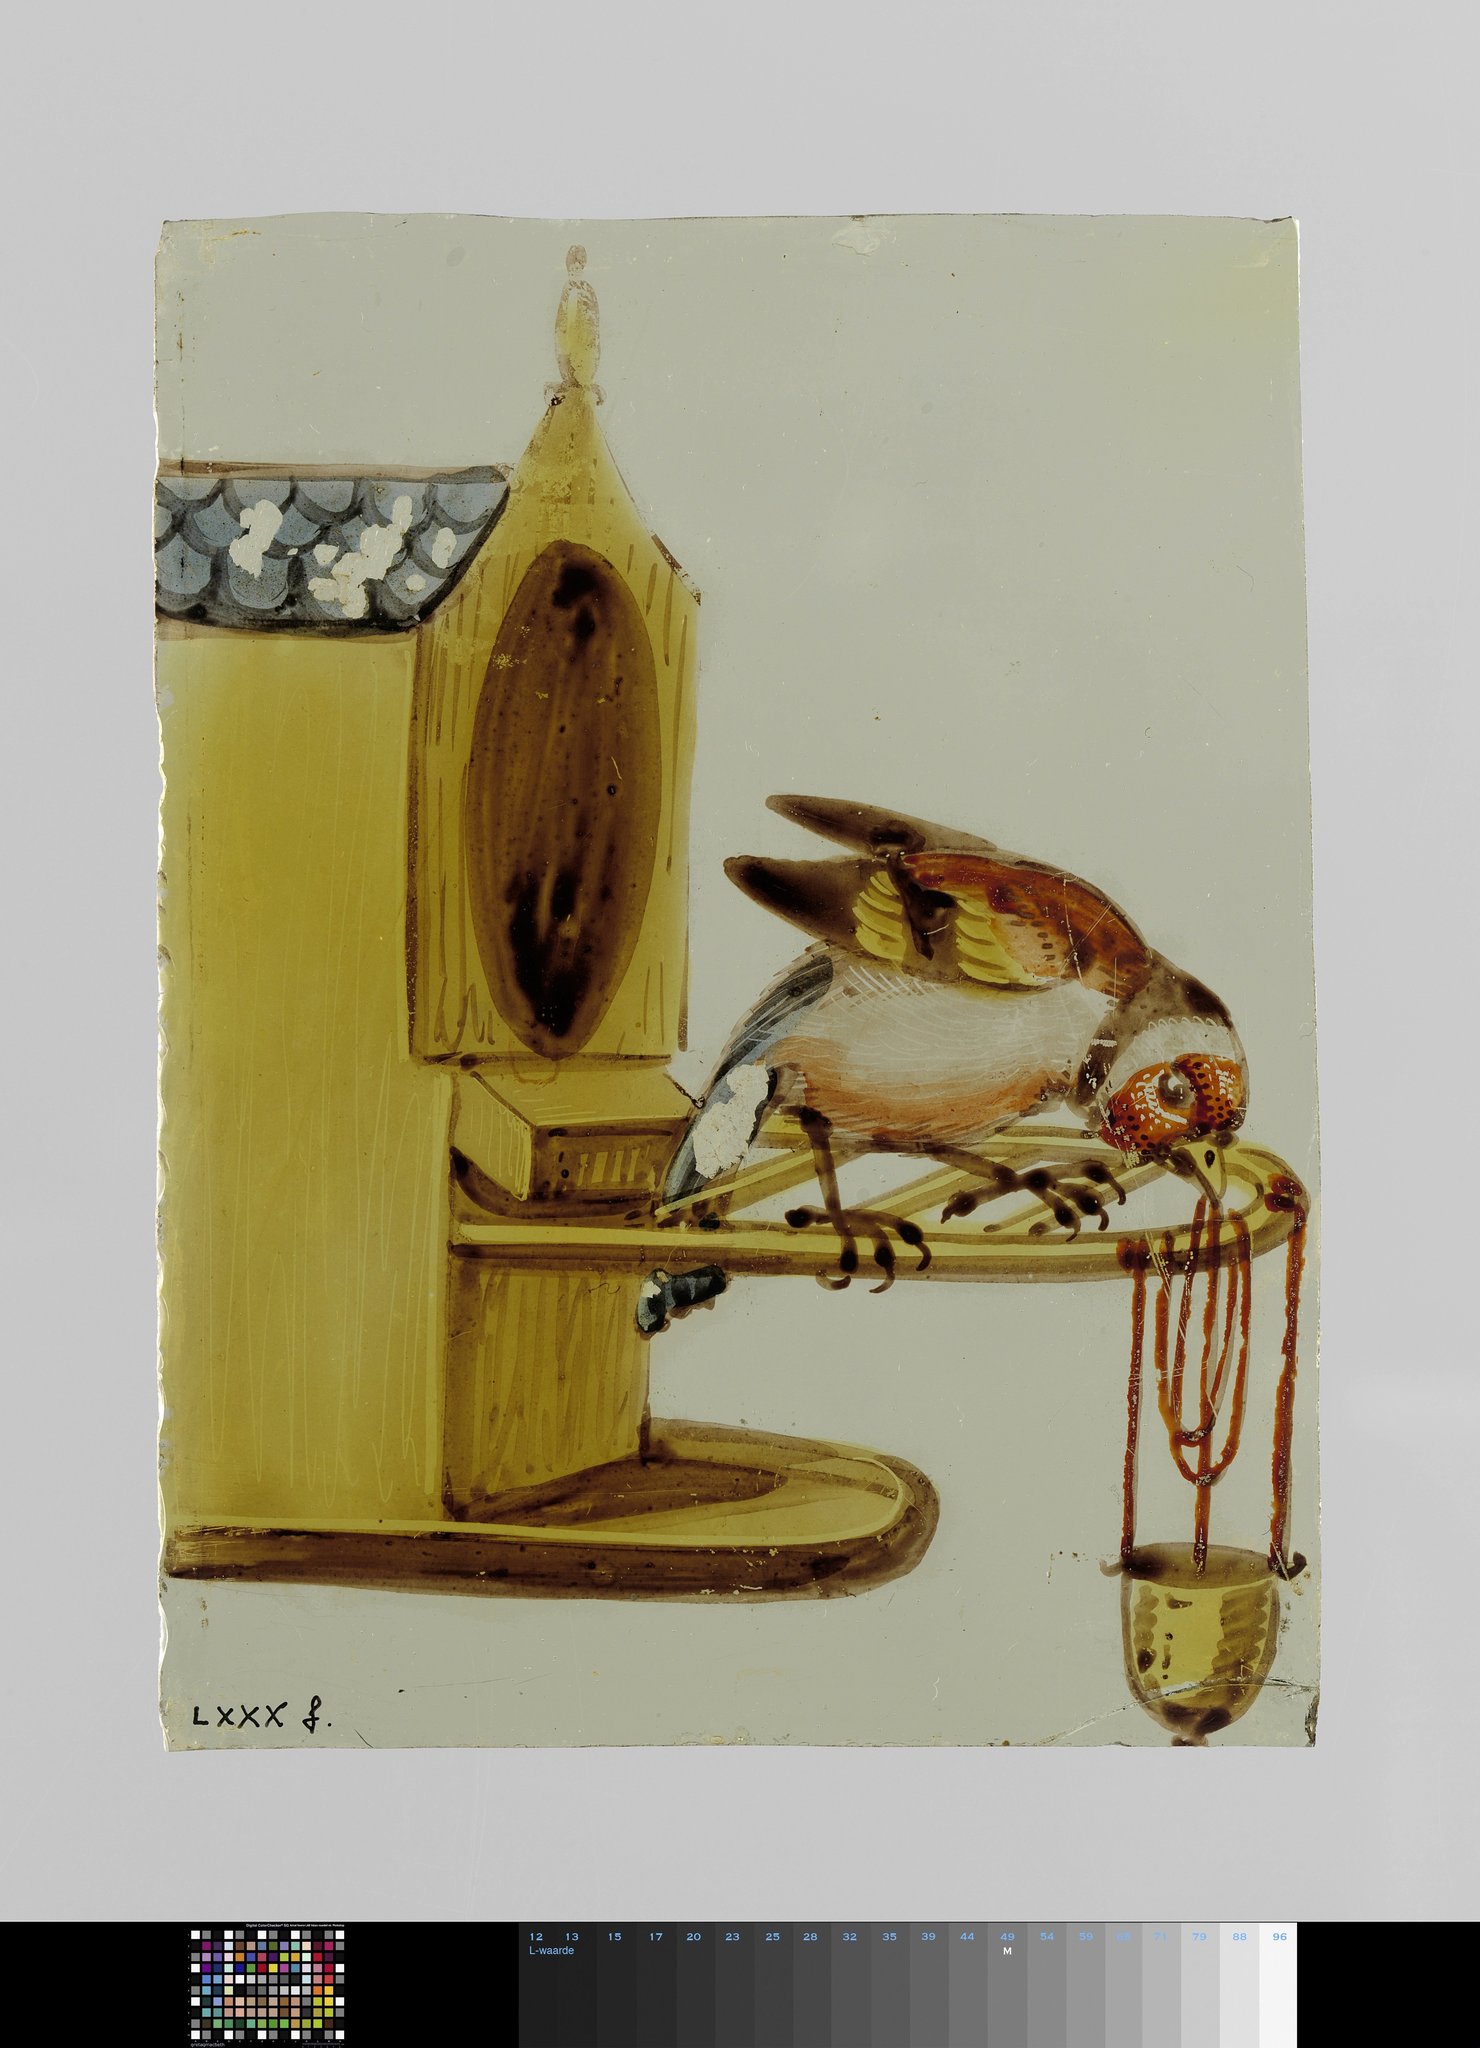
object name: light window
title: Ruit met een putter bij een vogelhuisje met voederbak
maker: Anonymous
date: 1650-1675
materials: glass, lead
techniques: enamel painting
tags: birds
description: Een ruit met emailschildering van een putter op de rand van een vogelhuisje. De vogel trekt een voederbakje omhoog.